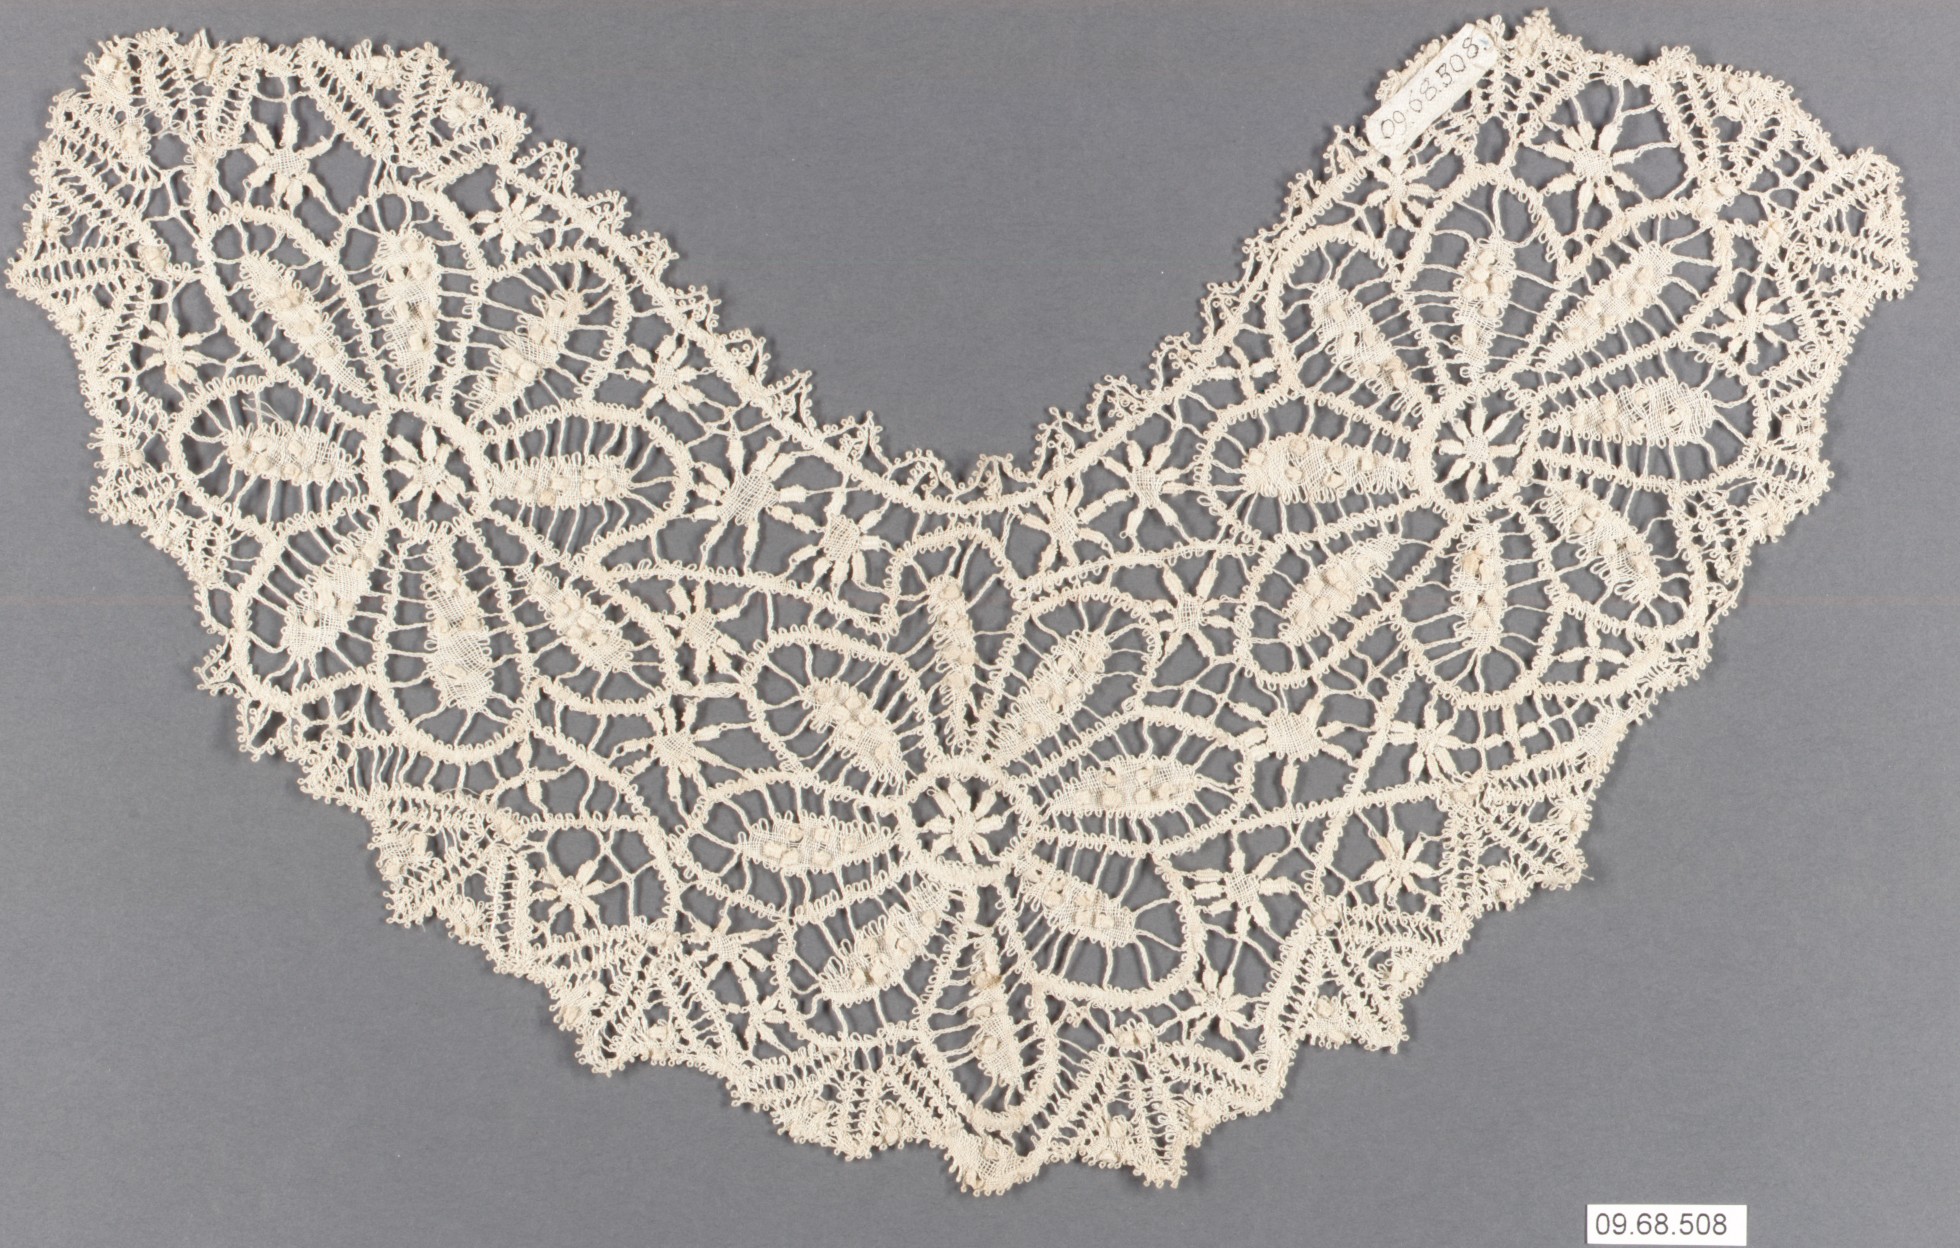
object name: cuff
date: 1801-1900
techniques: lace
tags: flowers